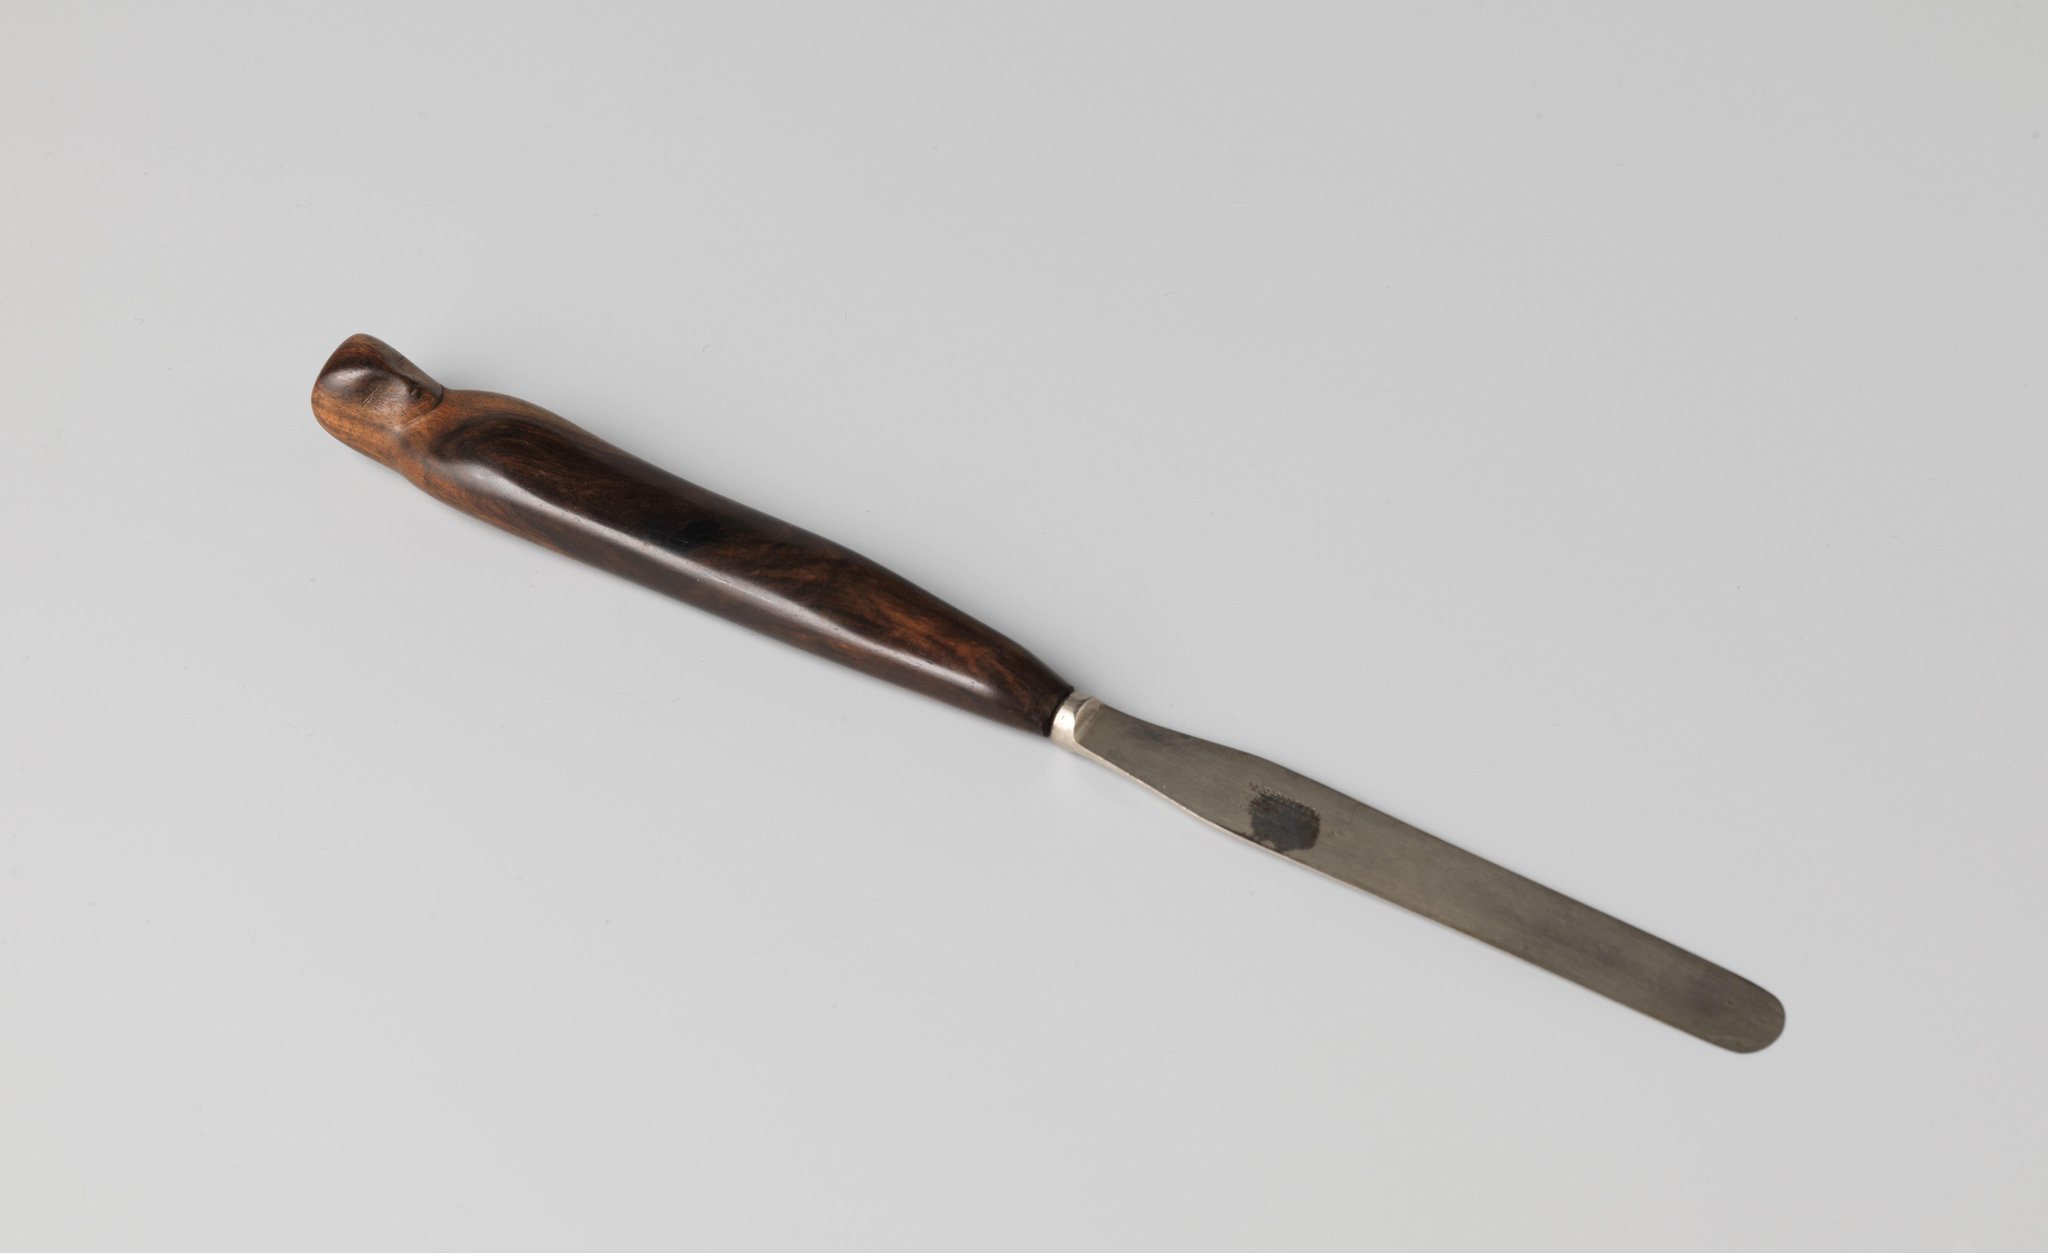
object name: letter opener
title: Brievenopener met houten handvat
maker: willem rädecker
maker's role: designer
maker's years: 1883-1971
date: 1925-1950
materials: steel, wood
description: Brievenopener van hout met metalen lemmet. Het houten handvat vertoont aan het uiteinde een kop.